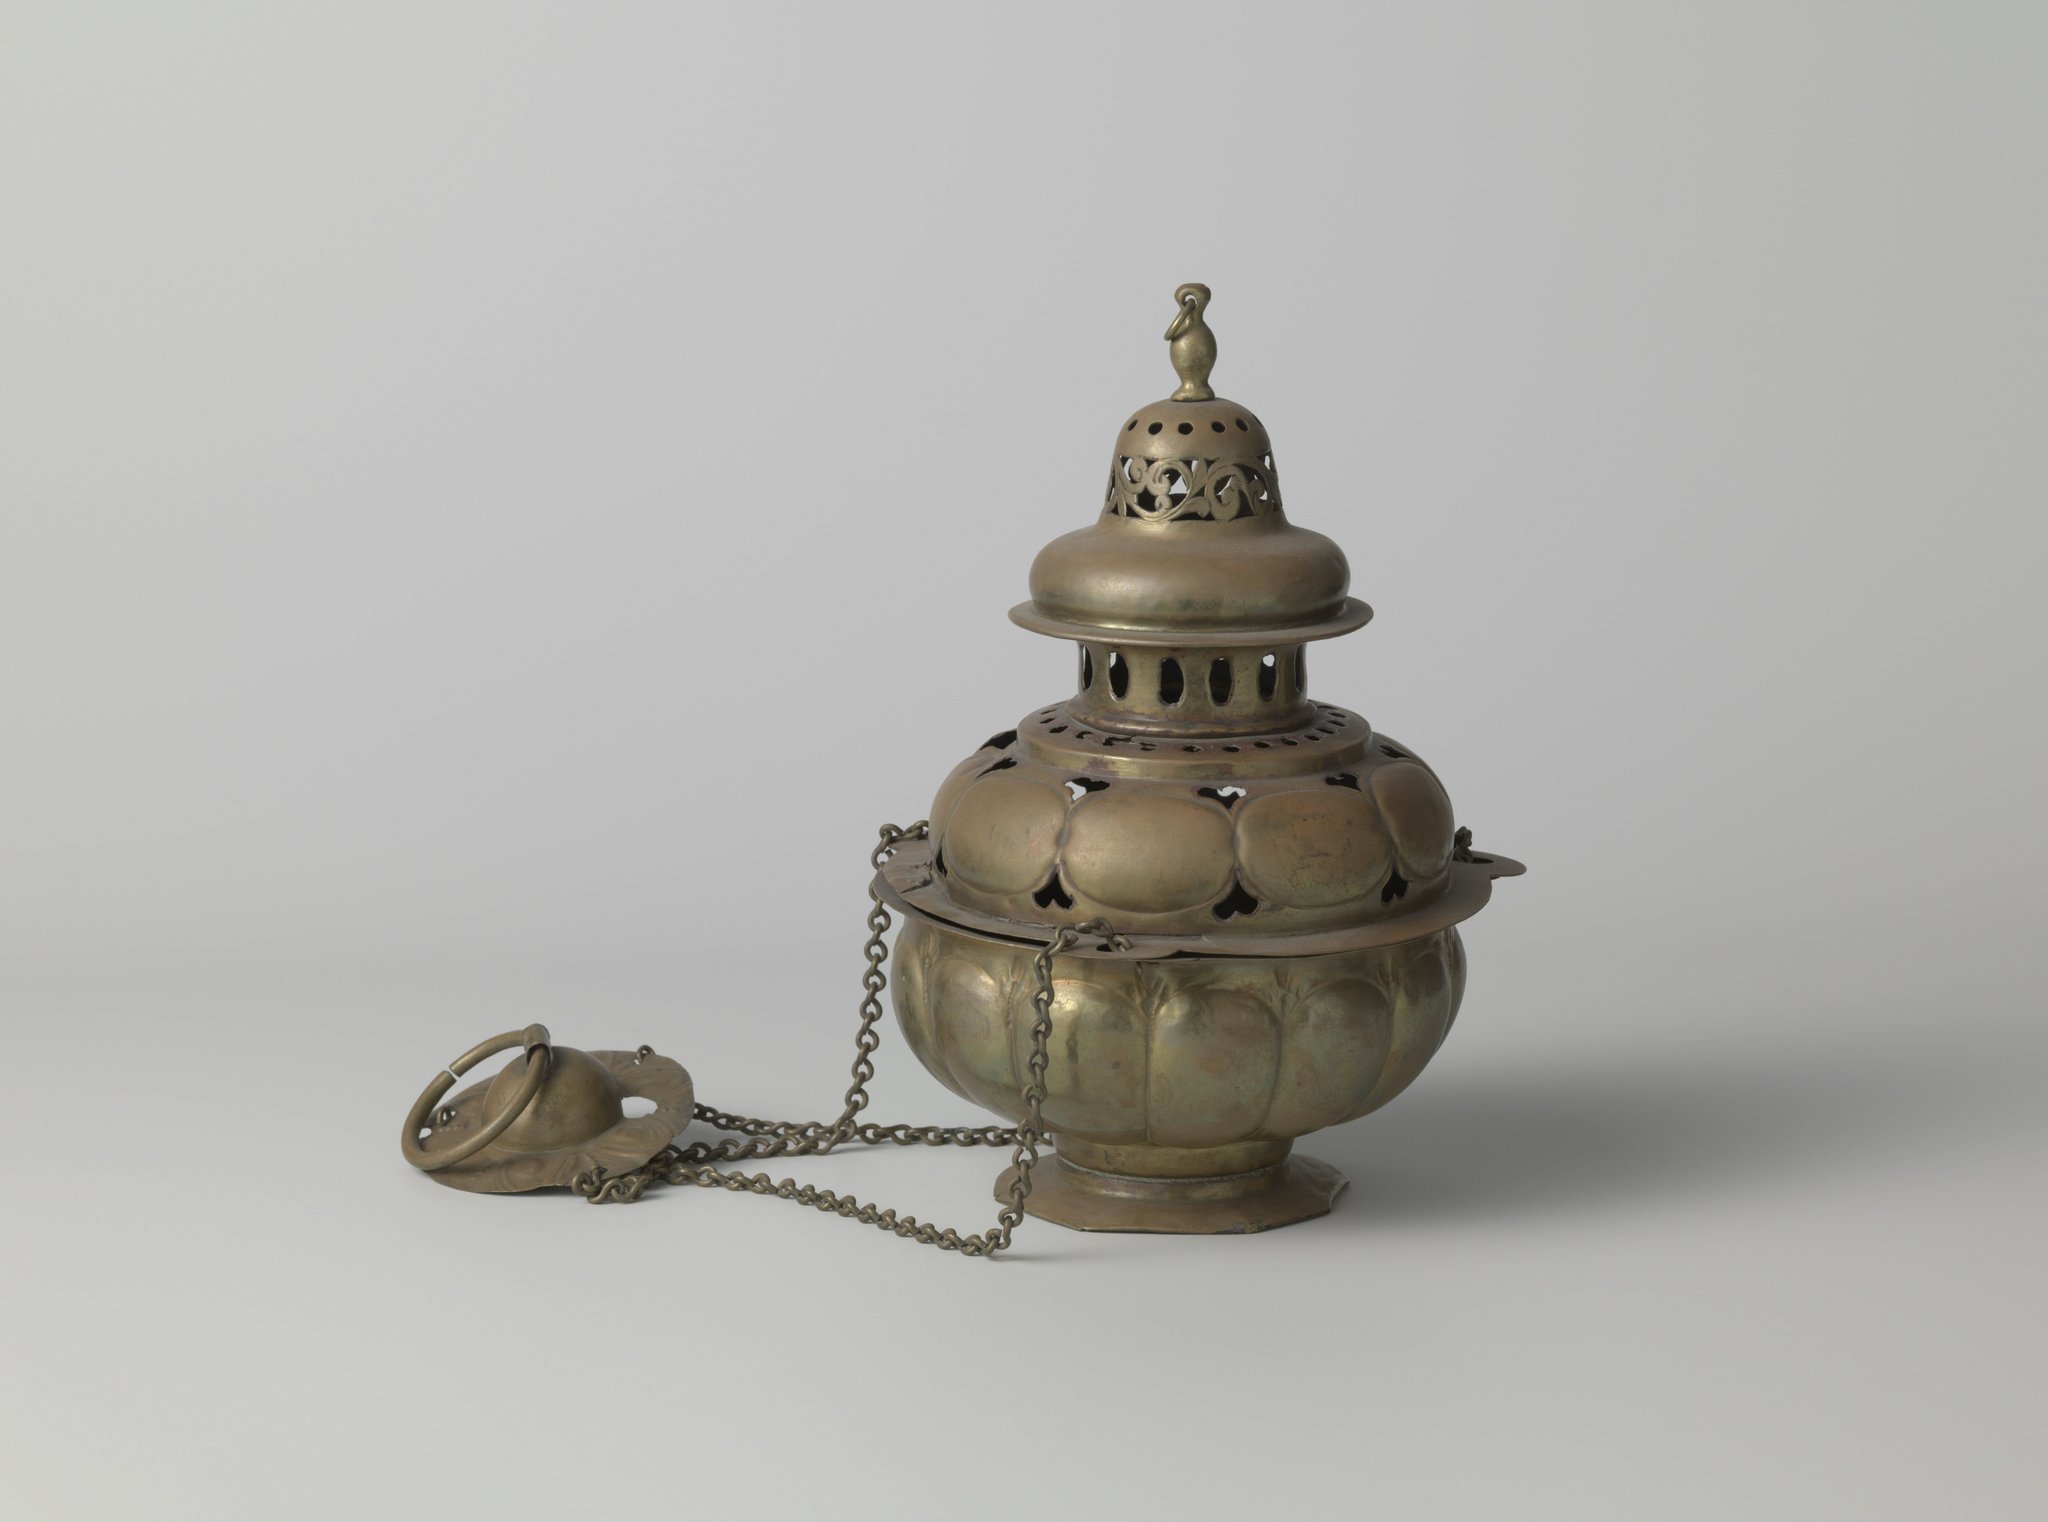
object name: censer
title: Wierookvat gedecoreerd met knorren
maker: Anonymous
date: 1700-1800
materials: brass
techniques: brazing, casting, embroidery, riveted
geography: southern netherlands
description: De onderdelen zijn uit plaatwerk gedreven, met uitzondering van de schakelkettingen en gegoten knop. De ronde met dertien knorren versierde kuip is op een verhoogde achthoekige voet geklonken. Kuip en deksel zijn voorzien van drie paar ogen. Het deksel heeft de vorm van een ronde torenbekroning, waarvan de lantaarn, die o.a. met uitgesneden rankwerk is versierd, op het bolle opengewerkte met negen lobben versierde onderstuk is gebraseerd. Het bolle midden van de ringdrager is op vele plaatsen hersteld. De kettingen zijn vernieuwd.